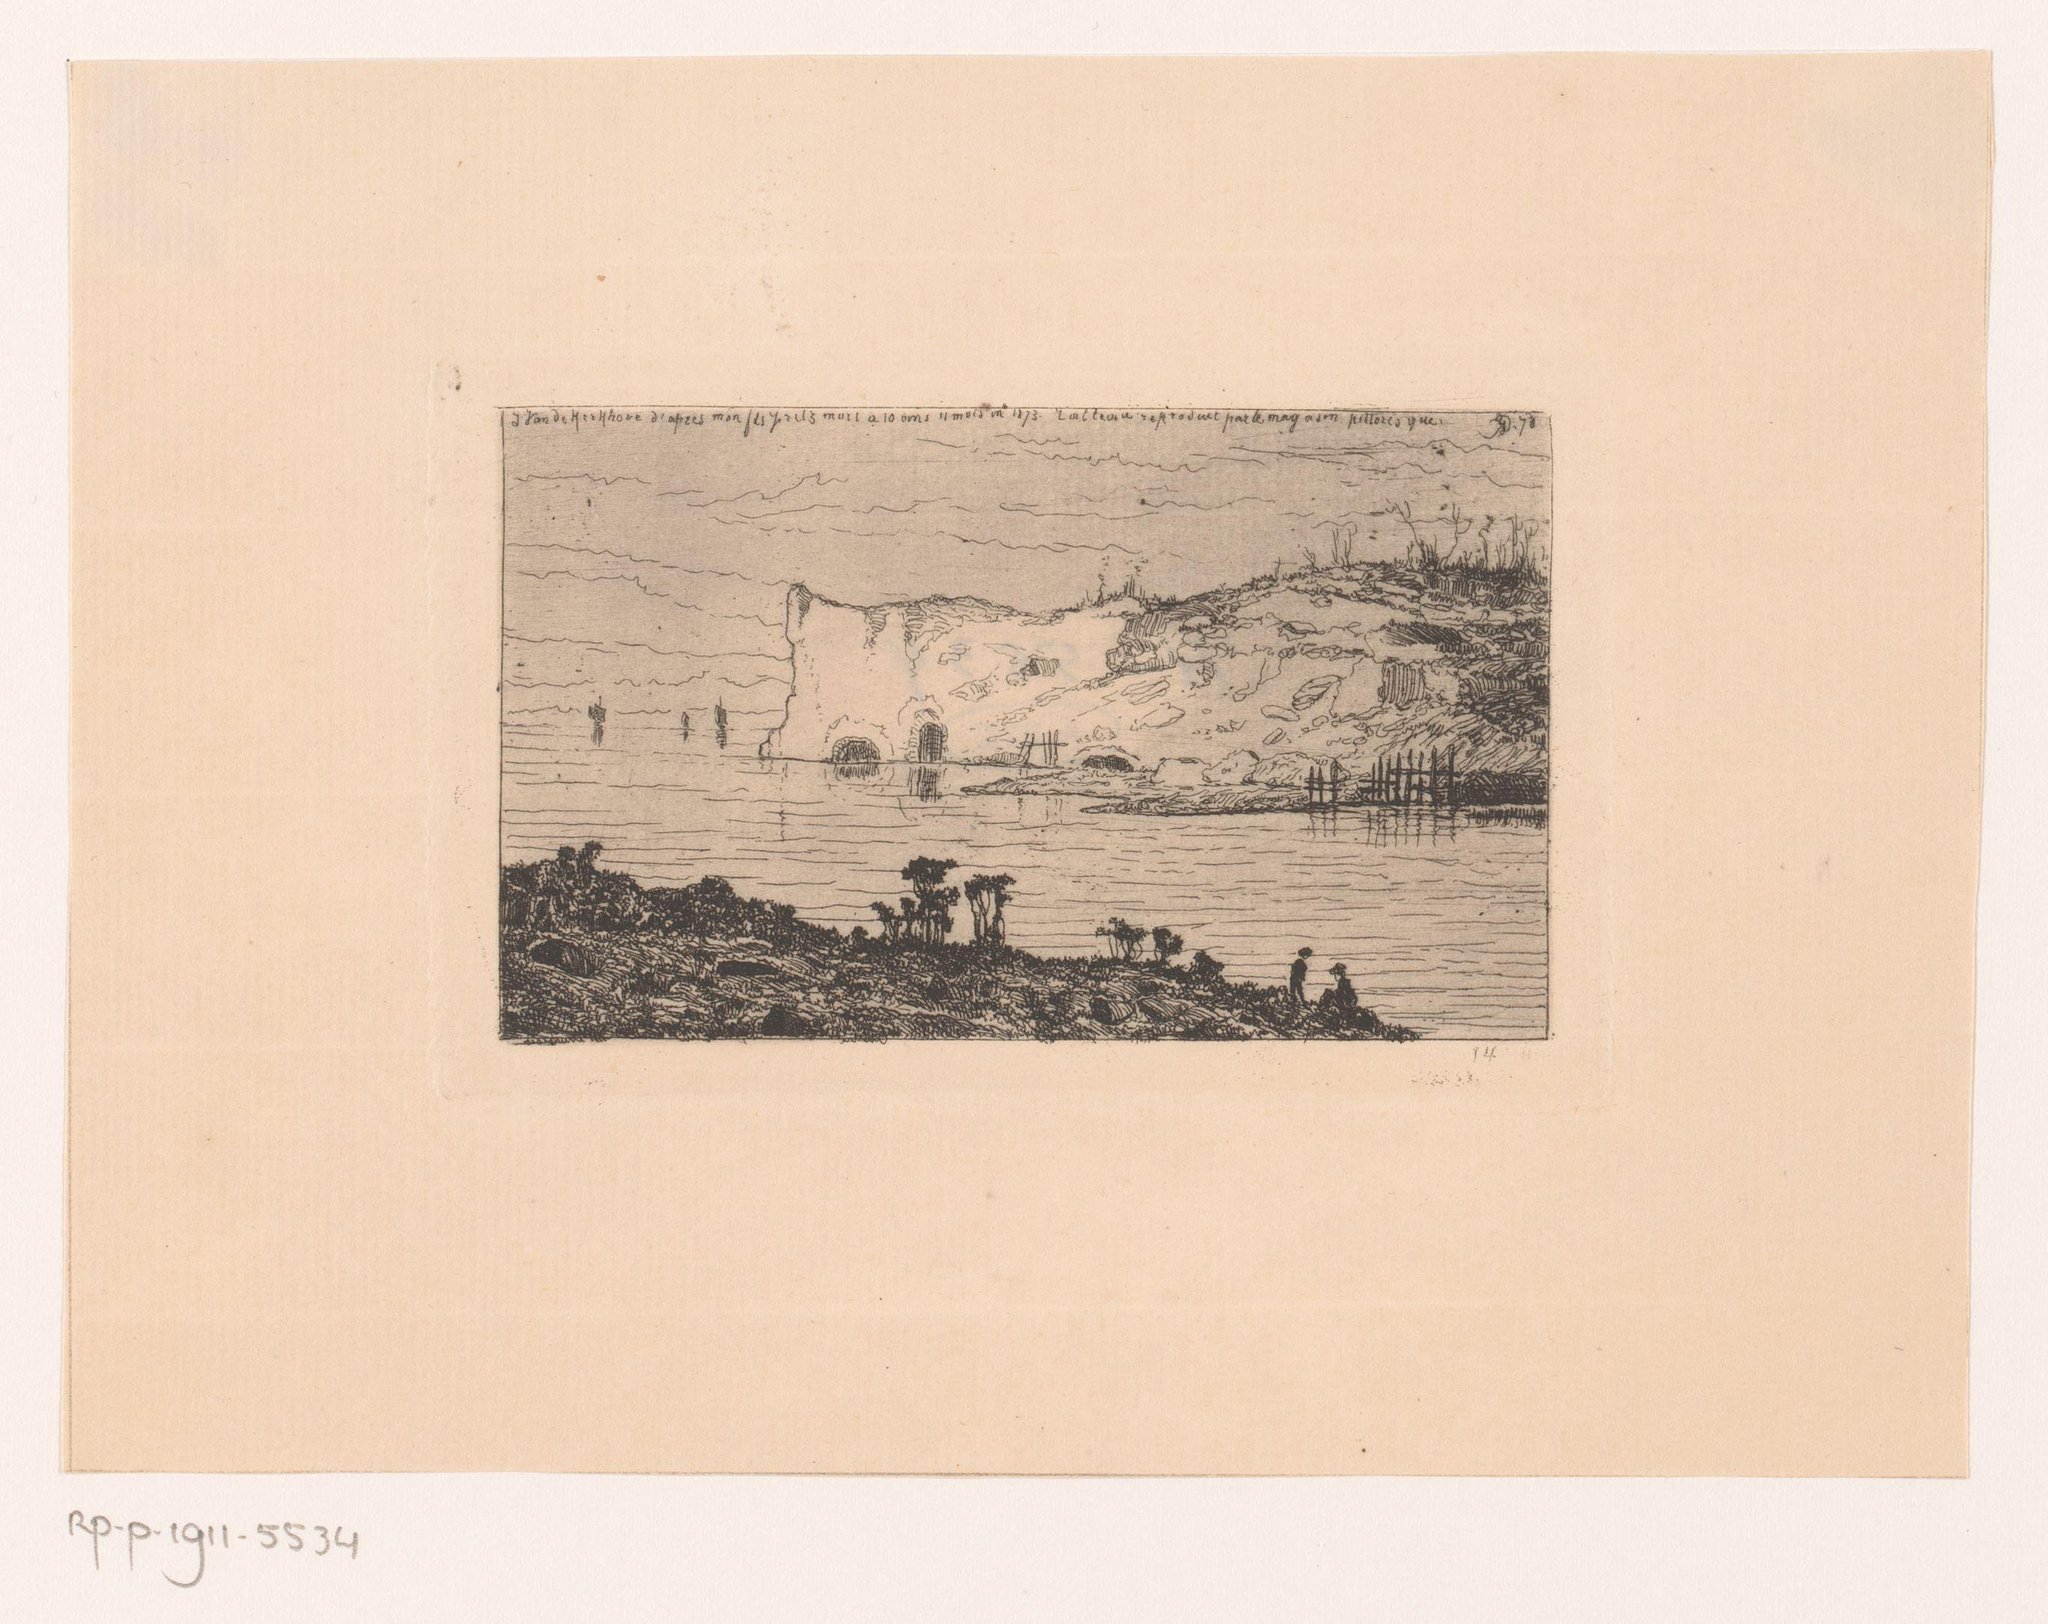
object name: print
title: Kliffen aan de kust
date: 1878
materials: paper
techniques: drypoint, etching, intaglio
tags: coastal cliff or crag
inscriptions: collector's mark: Lugt 2228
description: De etsen naar de schilderijen van Frédéric Van de Kerkhove werden na zijn dood door zijn vader en zuster gemaakt en uitgegeven in twee reeksen. De eerste werd in 1877 uitgegeven door het Journal des Beaux-Arts et de la Littérature: Cahier de 25 Eaux-fortes d'après Frédéric van de Kerkhove, gravées par son père et sa sœur. De tweede reeks van 126 etsen, ook in 1877, werd in Parijs uitgegeven bij A. Lévy onder de titel Cent eaux-fortes gravées par J. Van de Kerkhove d'après les tableaux de Frédéric Van de Kerkhove, mort en 1873 à l'âge de 10 ans et 11 mois.